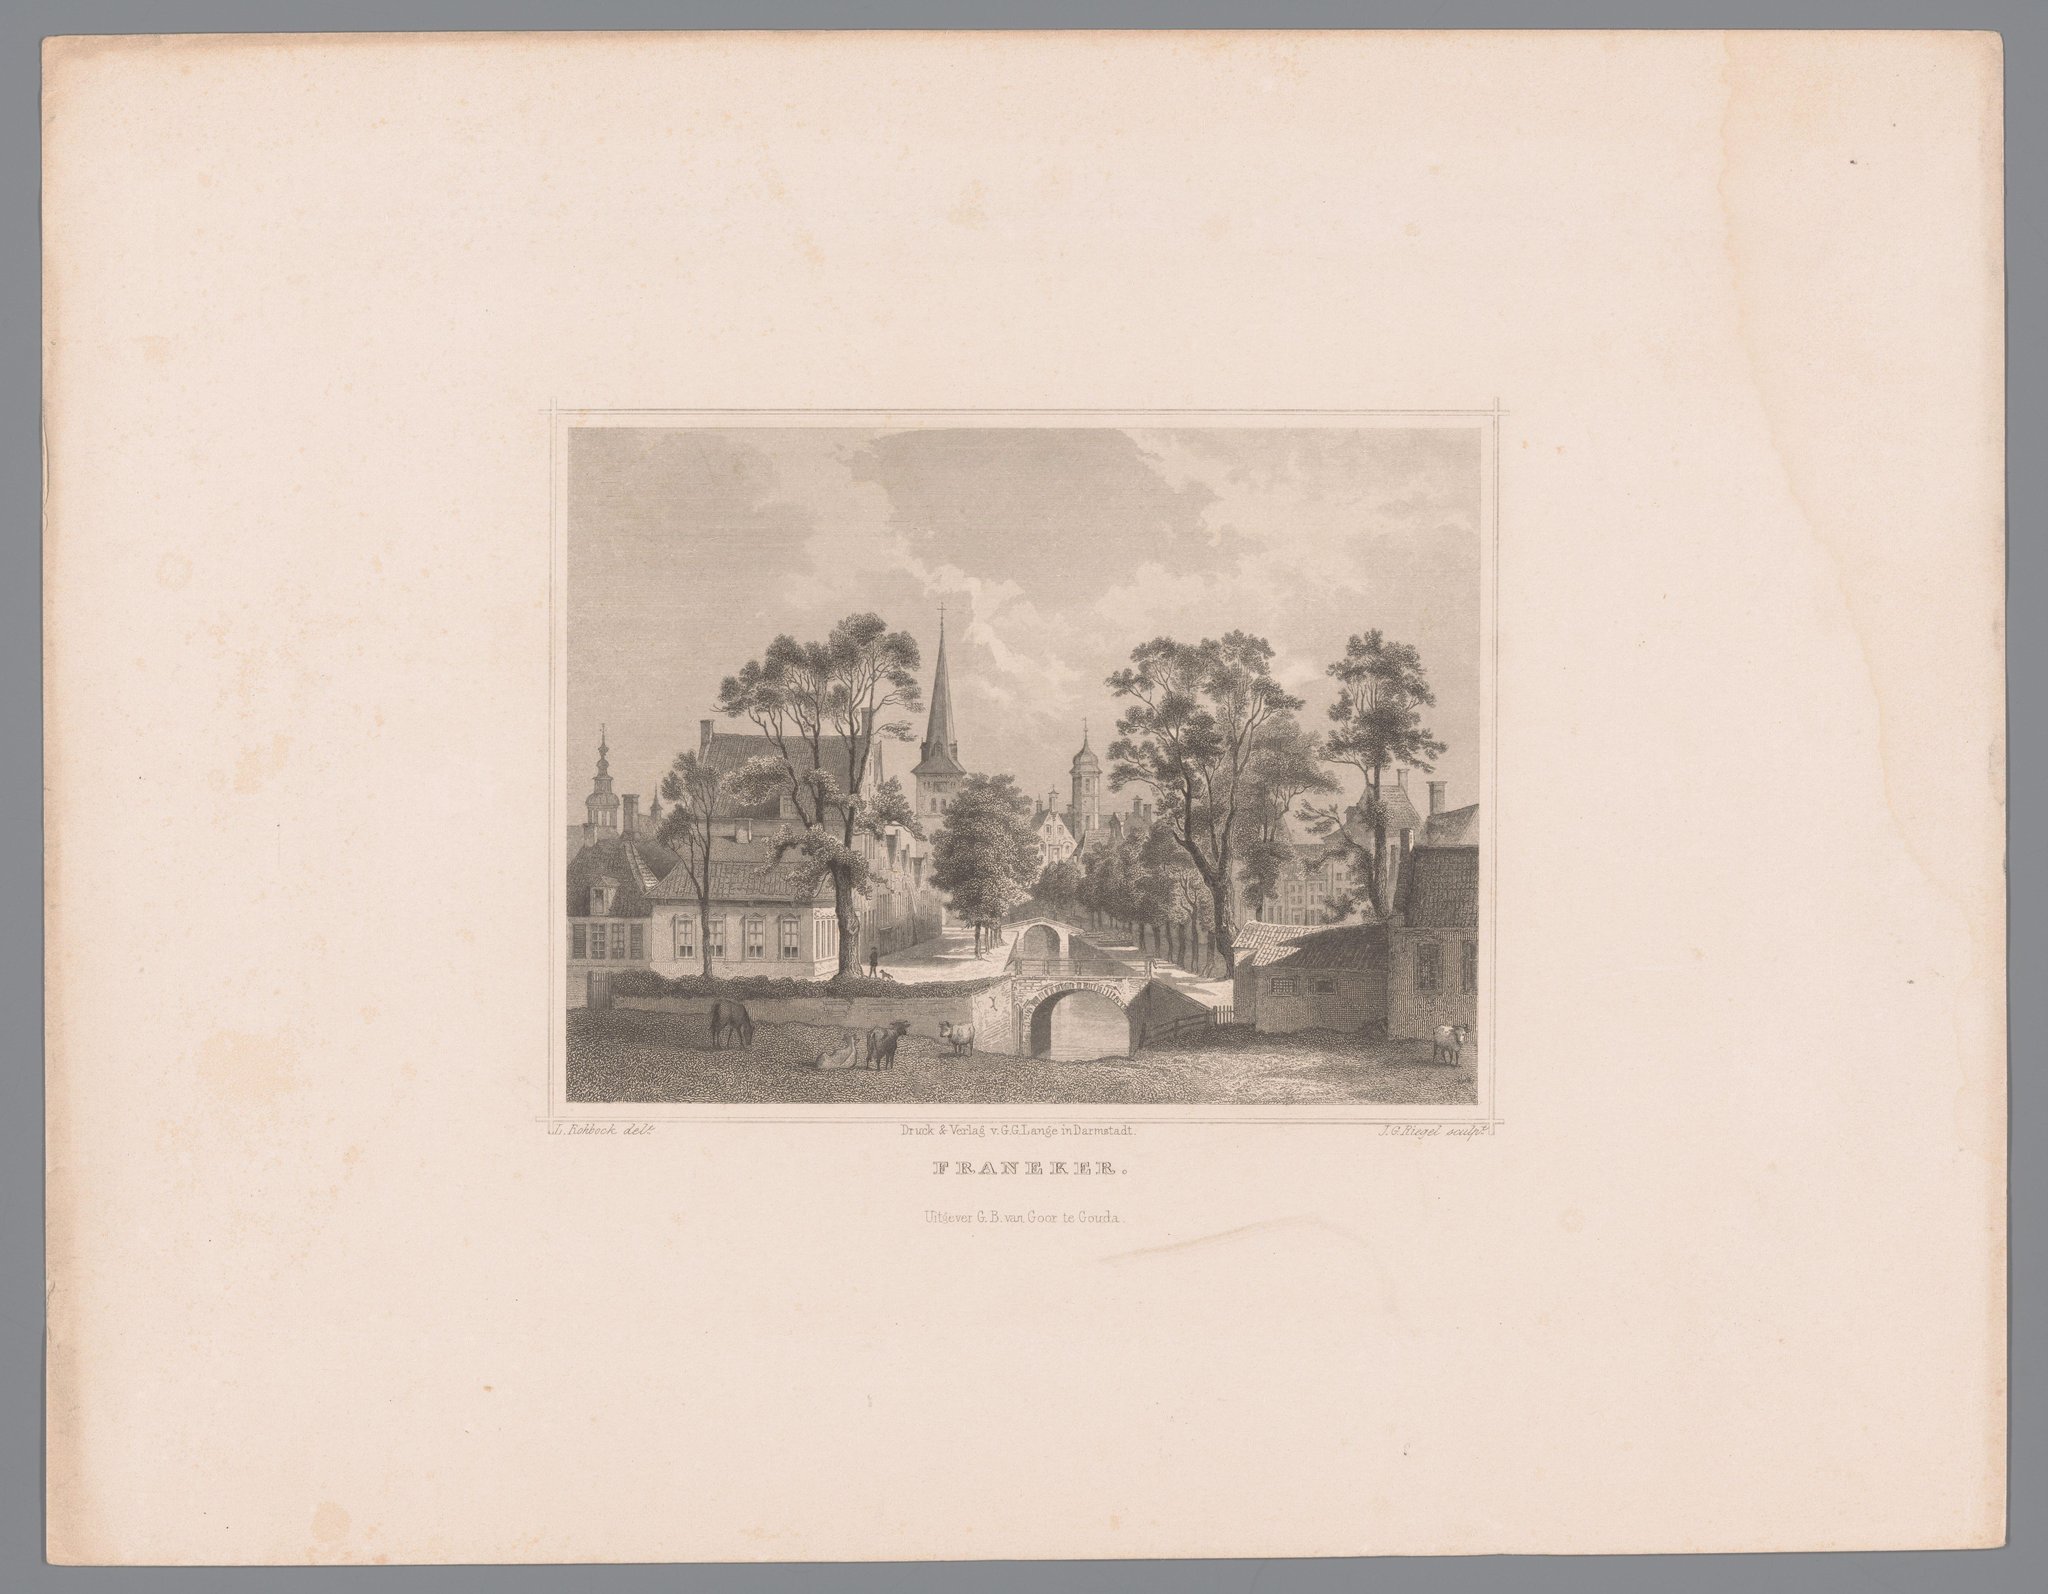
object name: print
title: Franeker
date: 1858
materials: paper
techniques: engraving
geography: gouda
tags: village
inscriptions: collector's mark: Lugt 2228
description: Prent verschenen in: Terwen, Johannes Leonardus. Het Koningrijk der Nederlanden: voorgesteld in eene reeks van naar de natuur geteekende schilderachtige gezigten en beschreven. Gouda: G.B. van Goor, 1858, dl. 3.